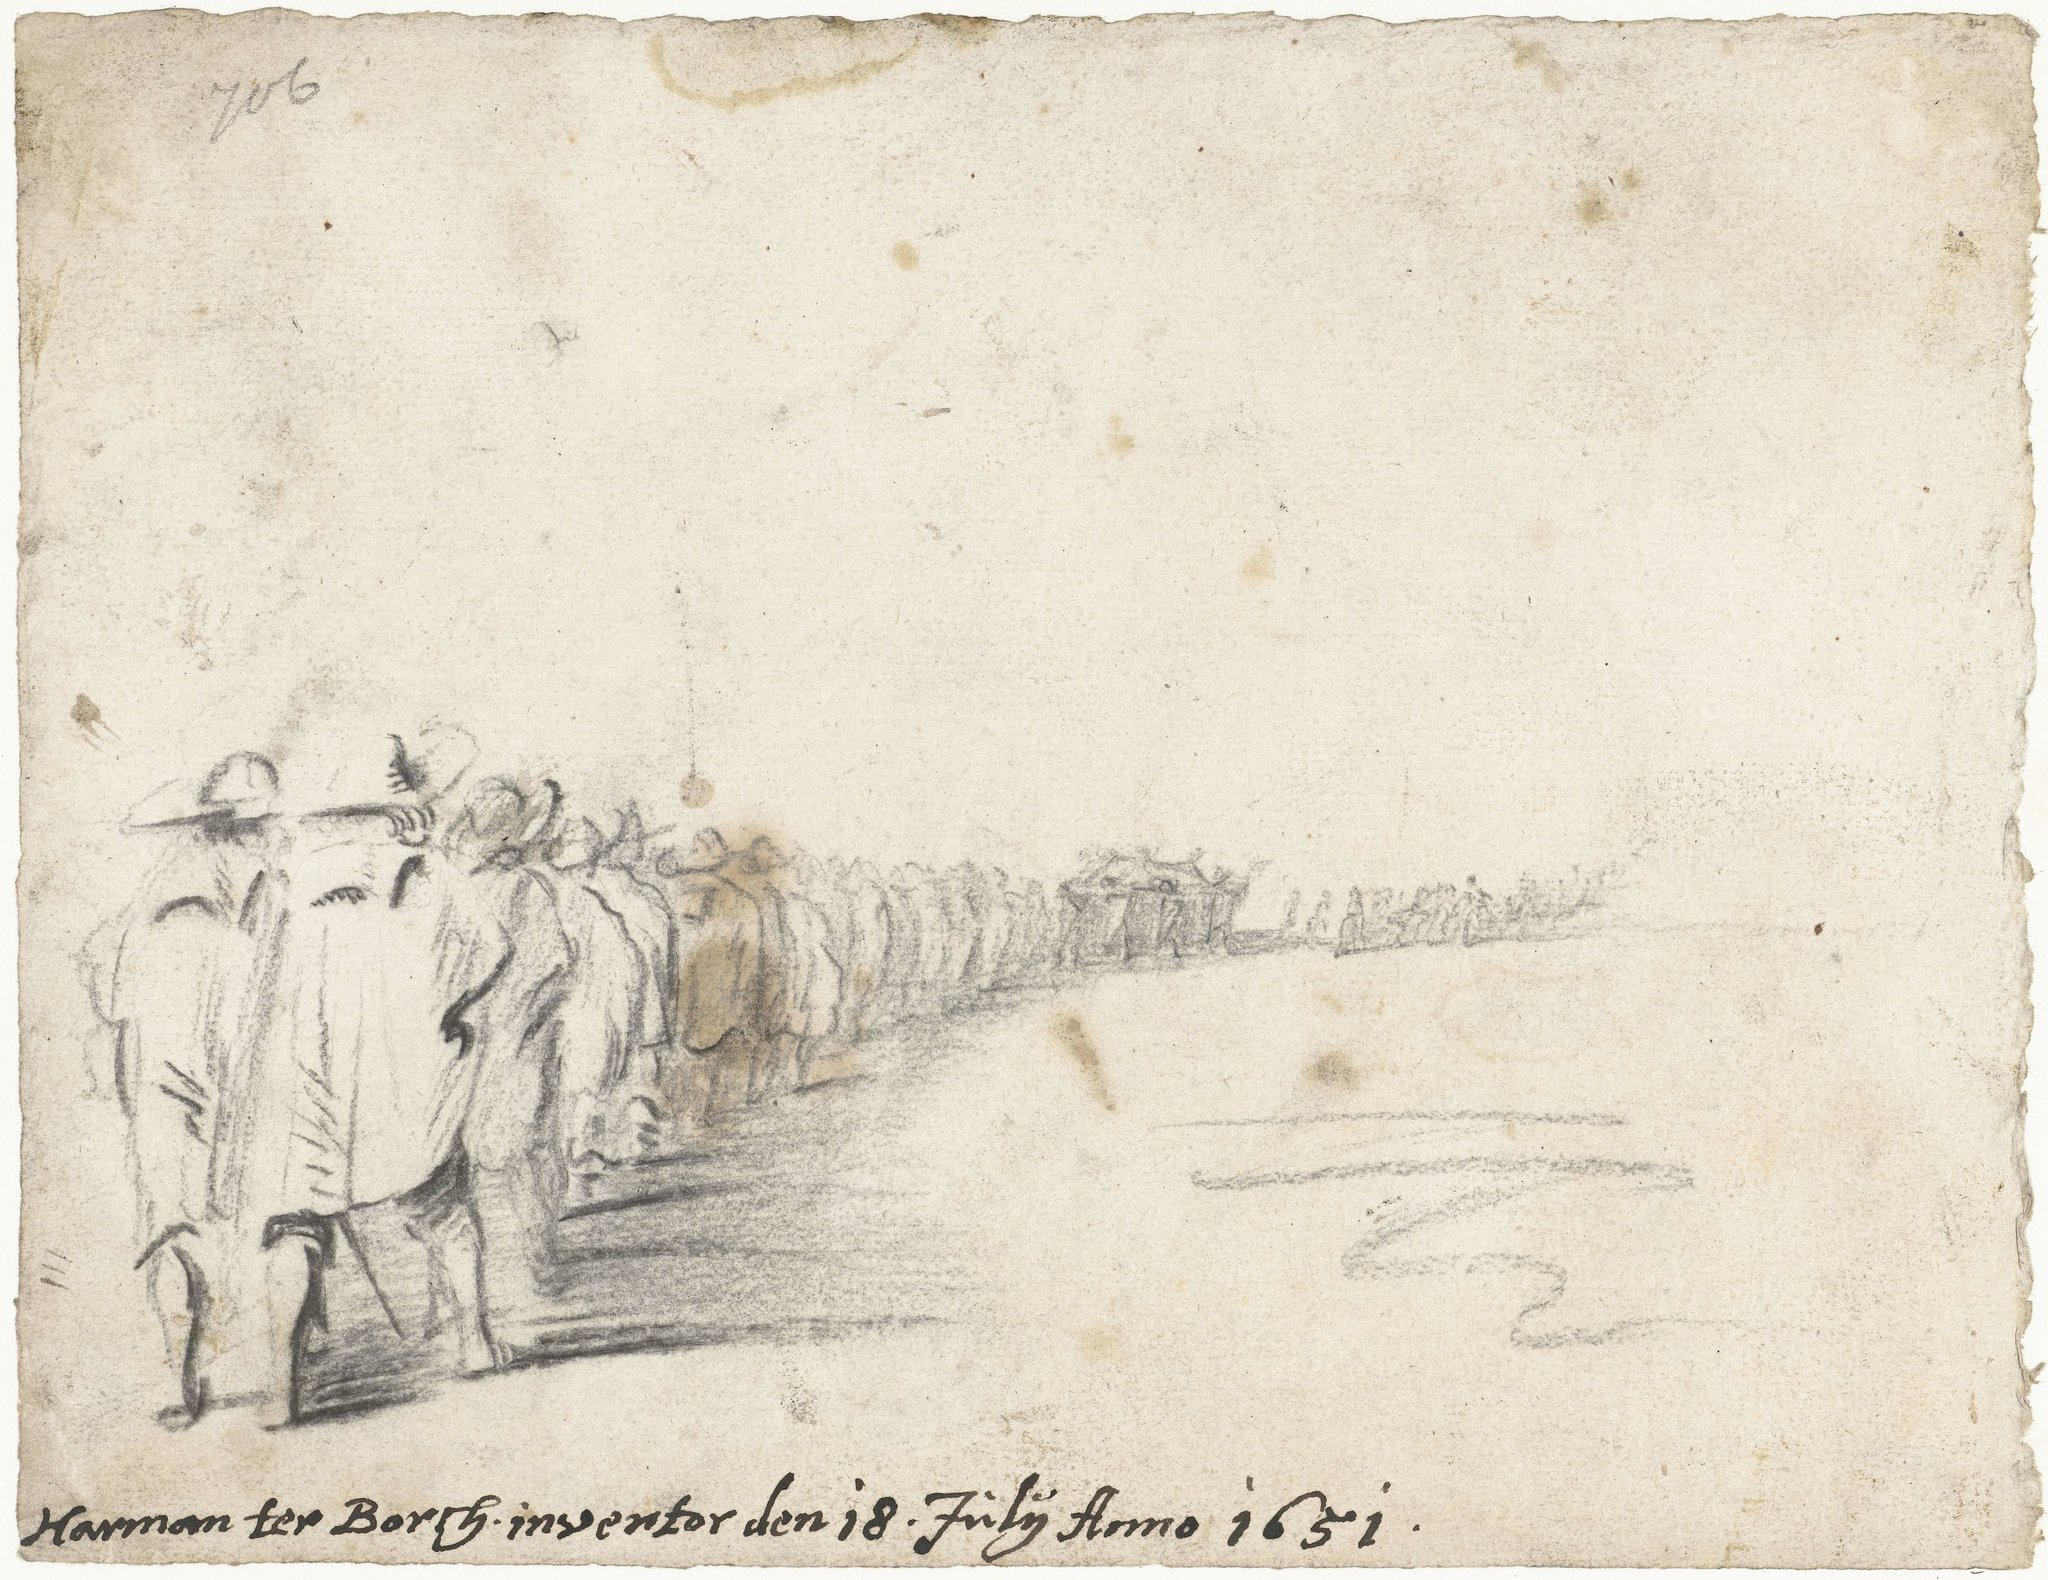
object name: drawing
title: Begrafenisstoet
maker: harmen ter borch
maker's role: draughtsman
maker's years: 1638-1677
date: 1651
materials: chalk, paper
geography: zwolle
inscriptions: annotation: ‘Harman ter Borch. inventor den 18. Julij Anno 1651’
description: Begrafenisstoet bestaande uit rouwenden die een lijkbaar volgen; vooraan een nauwelijks te onderscheiden rij ruiters.